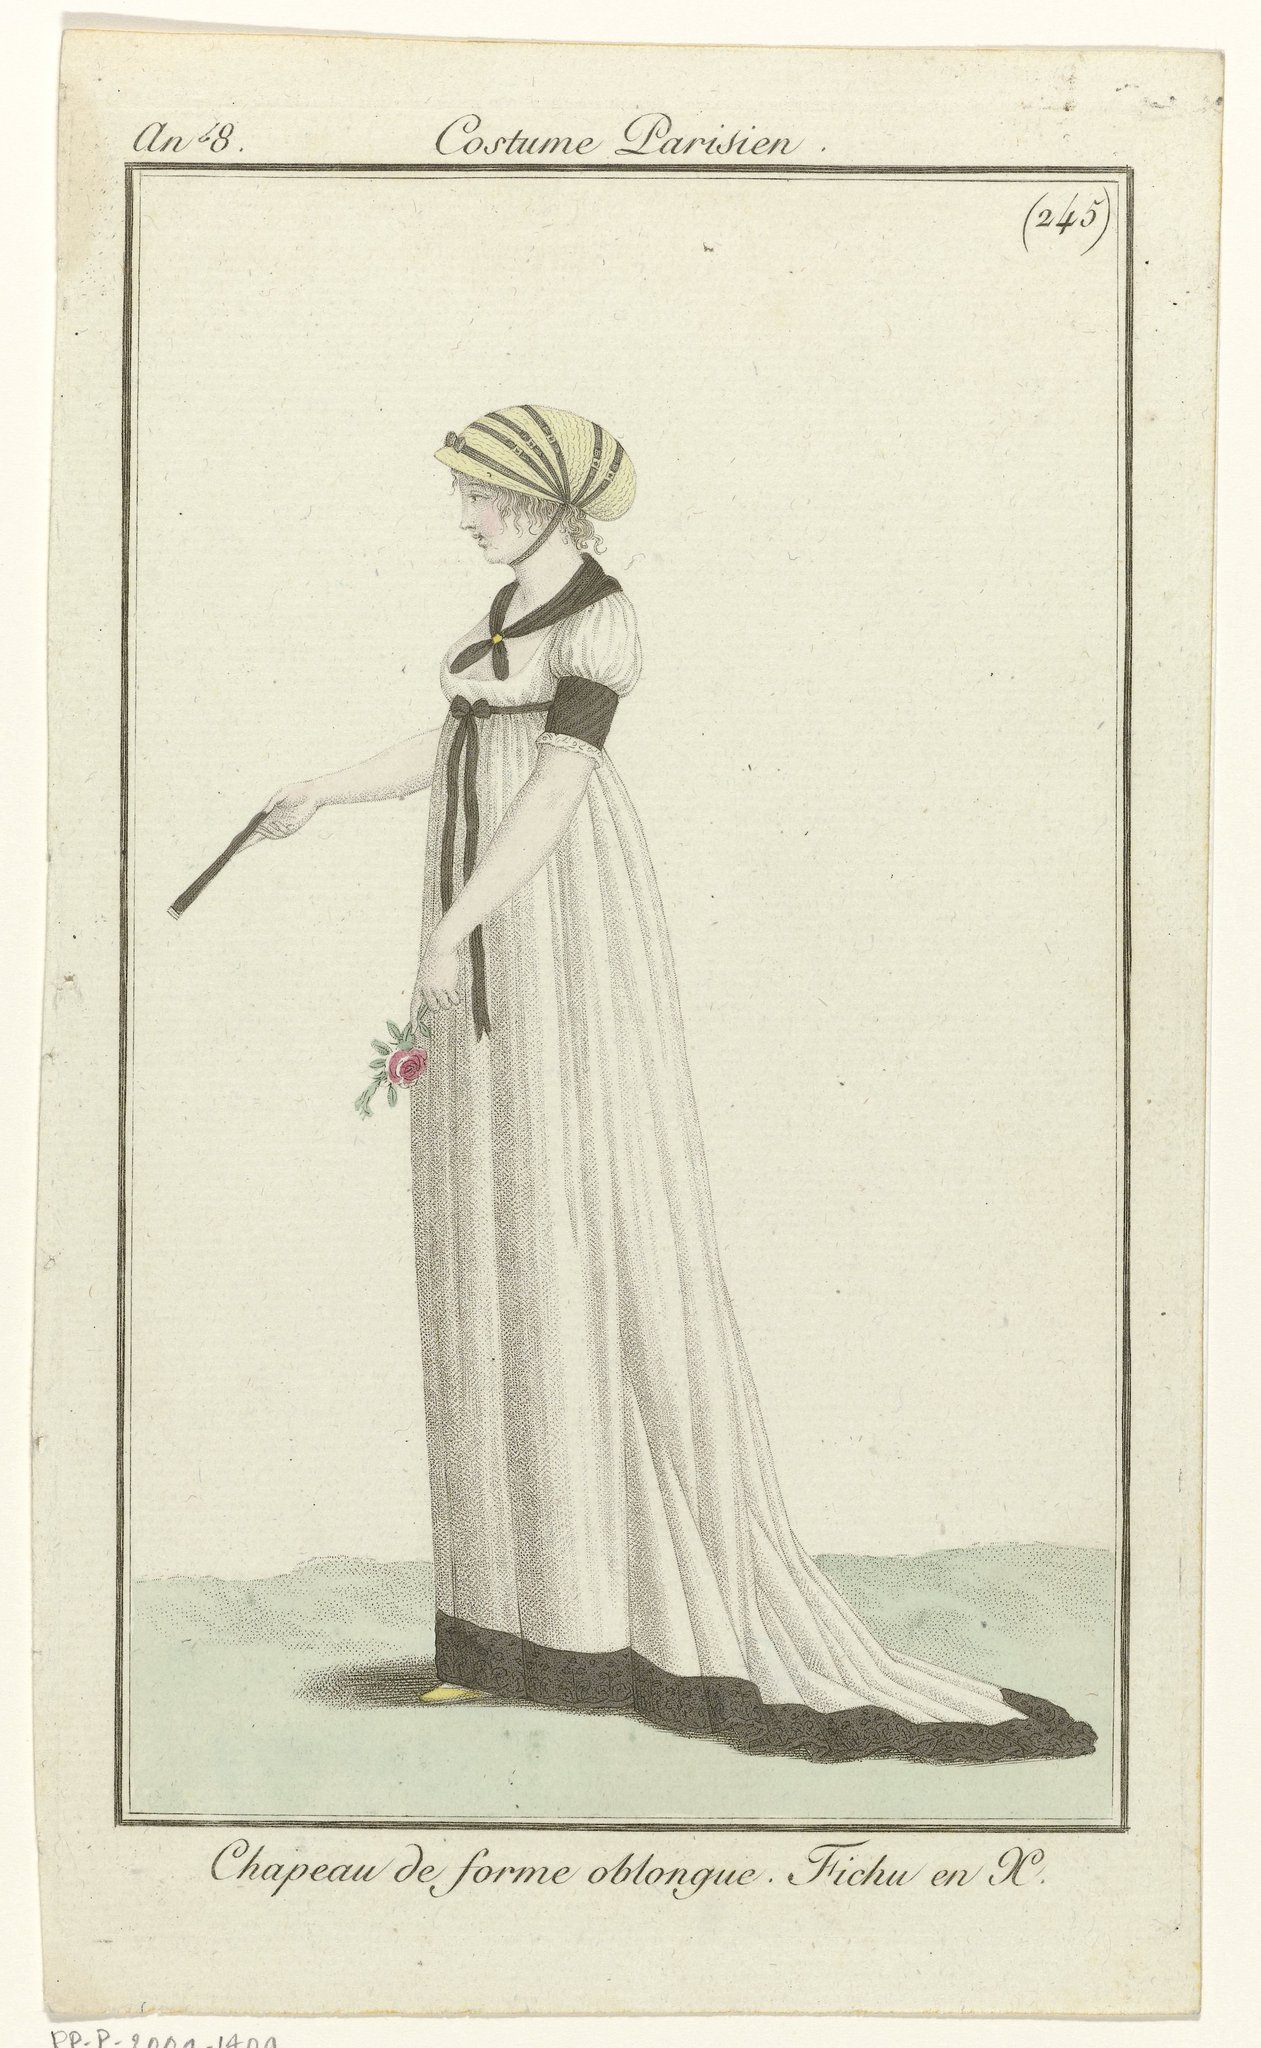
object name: fashion print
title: Journal des Dames et des Modes, Costume Parisien, 17 sept. 1800, An 8 (245) : Chapeau de form (...)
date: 1800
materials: paper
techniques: engraving, hand coloring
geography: paris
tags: head-gear (+ women's clothes), fashion plates, shoes, sandals (+ women's clothes), dress, gown (+ women's clothes), fan (+ women's clothes), flowers: rose, piece of clothing covering the breast or décolleté (fichu) (+ women's clothes)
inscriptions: caption: ‘Chapeau de forme oblongue. Fichu en X.’, title: ‘Costume Parisien.’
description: Langwerpige hoed met band onder de kin. Fichu in X-vorm. Japon met korte mouwen en sleep, afgezet met een contrasterende sierband. Waaier. De prent maakt deel uit van het modetijdschrift Journal des Dames et des Modes, uitgegeven door Pierre de la Mésangère, Parijs, 1797-1839.